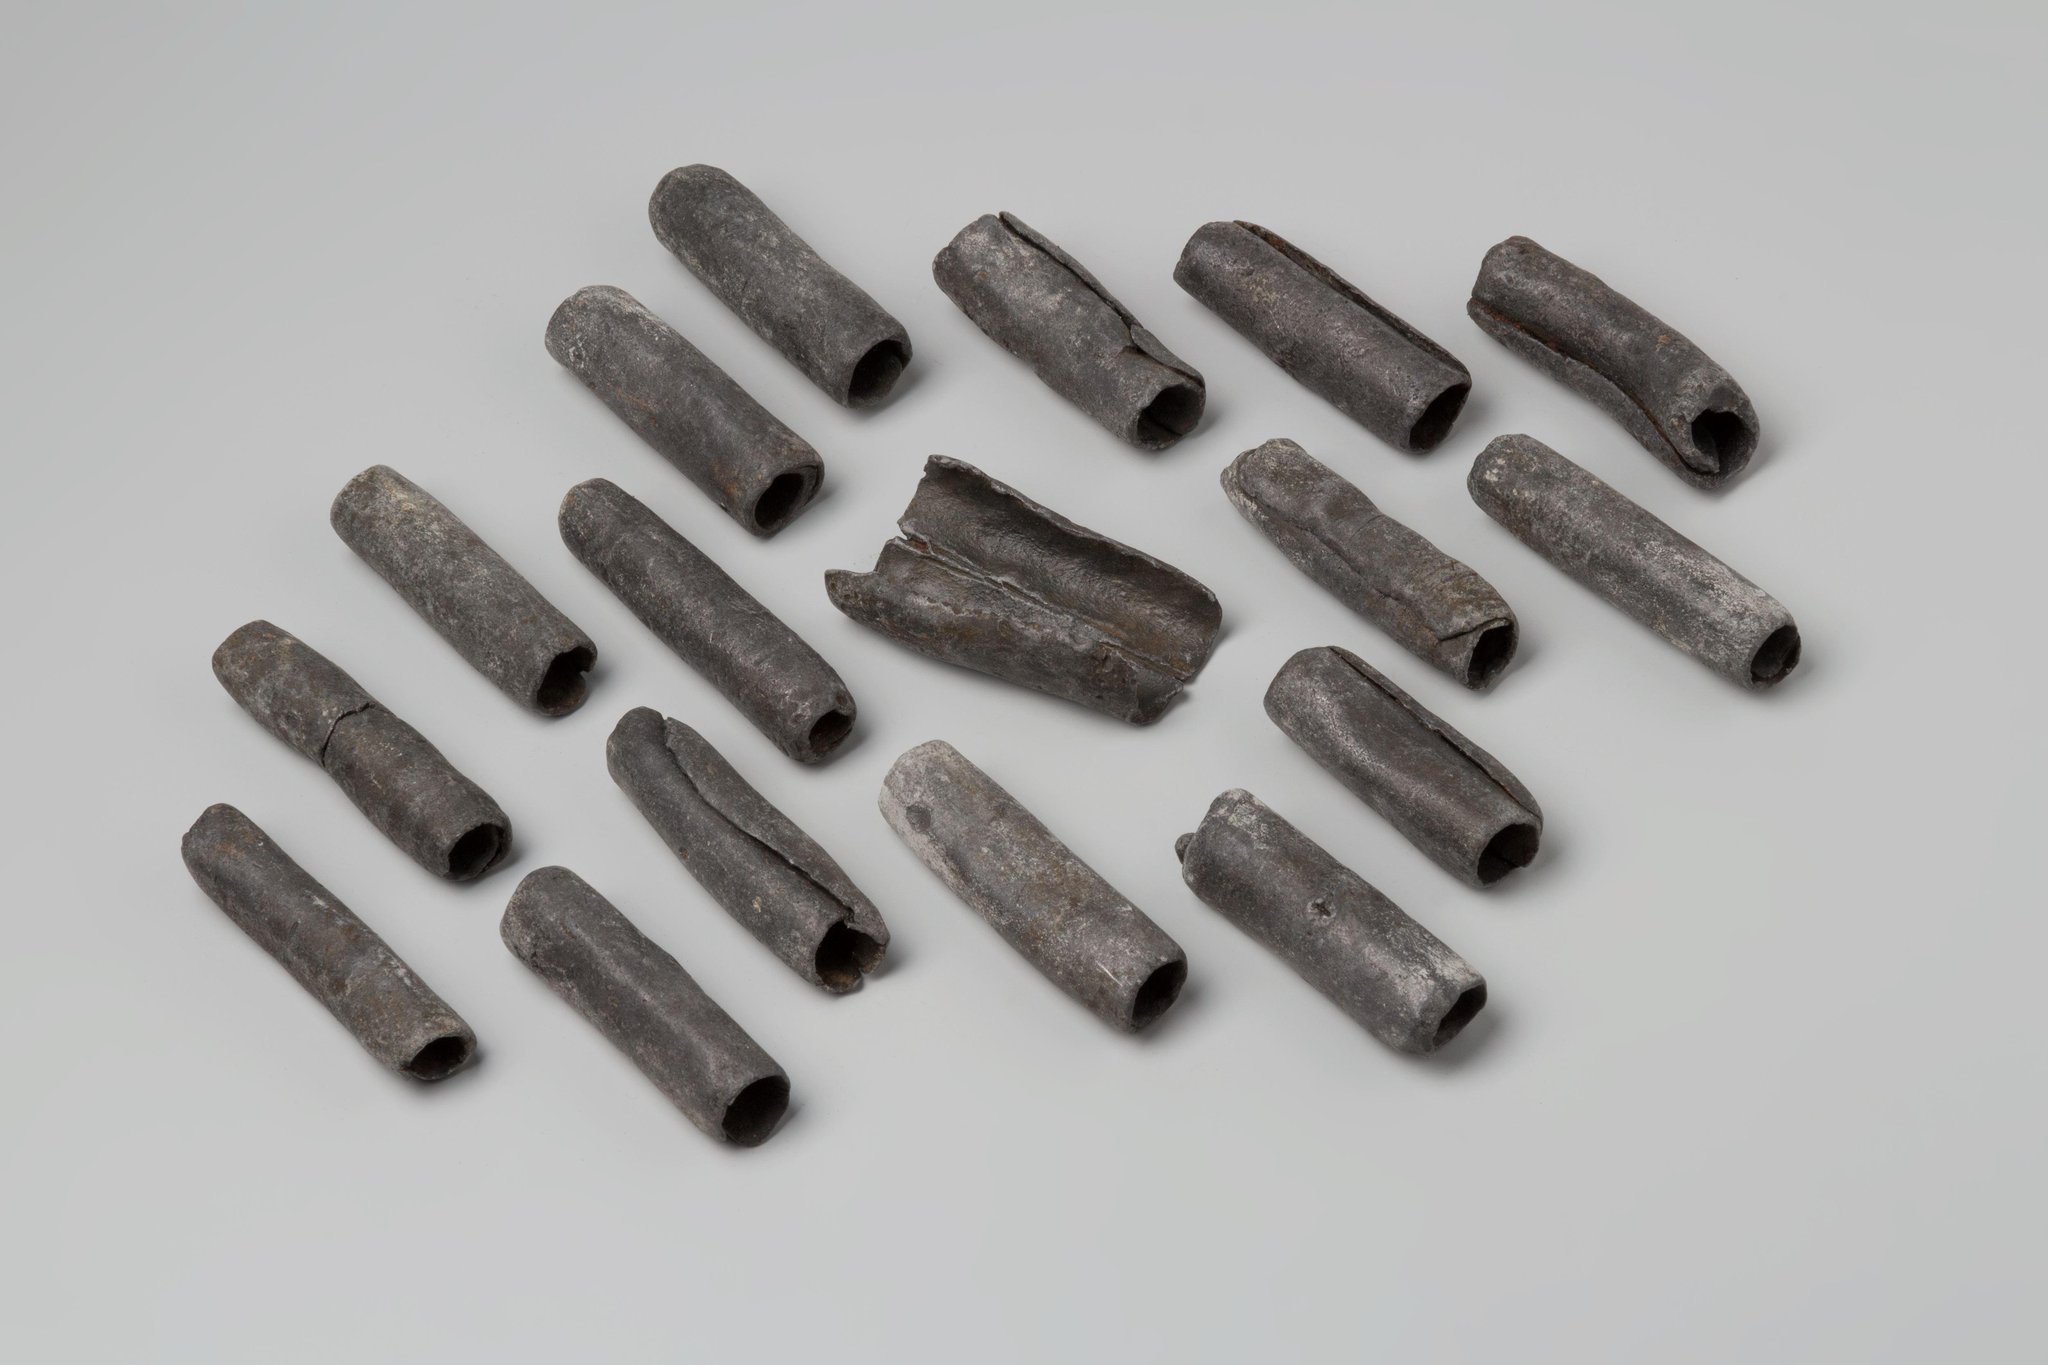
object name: lead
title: Loden rol uit het wrak van de Oost-Indiëvaarder 't Vliegend Hart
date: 1700-1735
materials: lead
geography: middelburg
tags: 't vliegend hart (schip), verenigde oostindische compagnie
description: Deze loden buisjes zijn vermoedelijk afkomstig van visnetten ofwel op TVliegend Hart zelf ofwel van vissers die hun netten aan het wrak verloren.